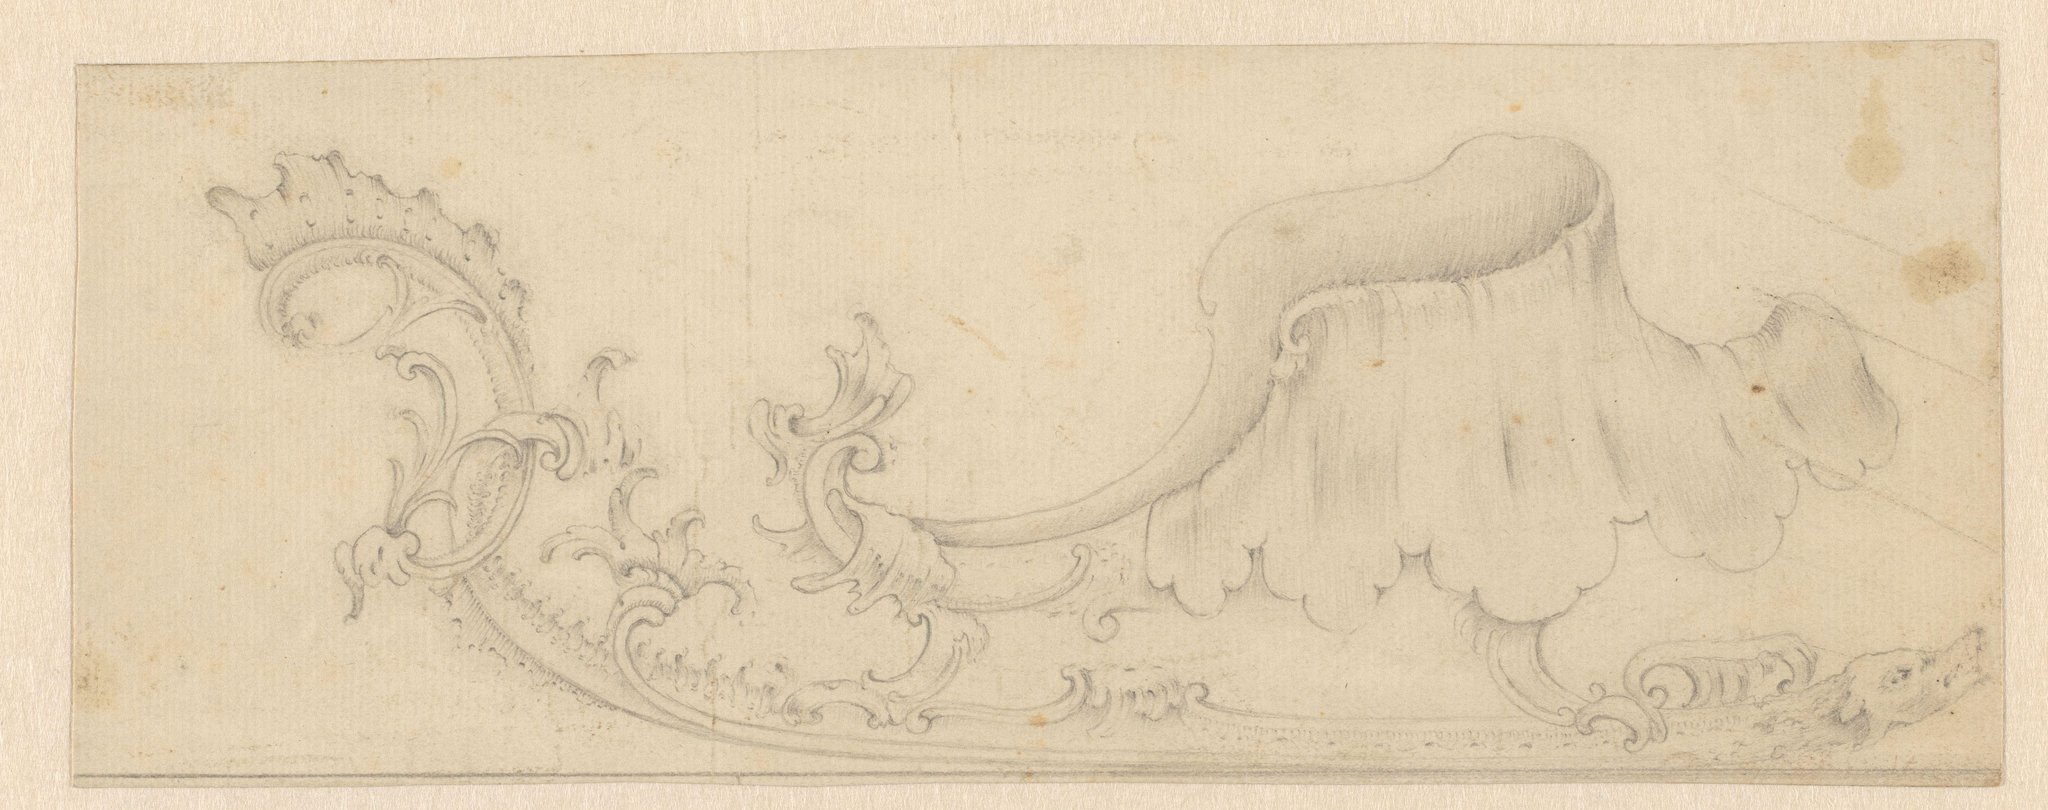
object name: drawing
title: Ontwerp voor een slede in rococo-stijl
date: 1750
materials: graphite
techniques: drawing